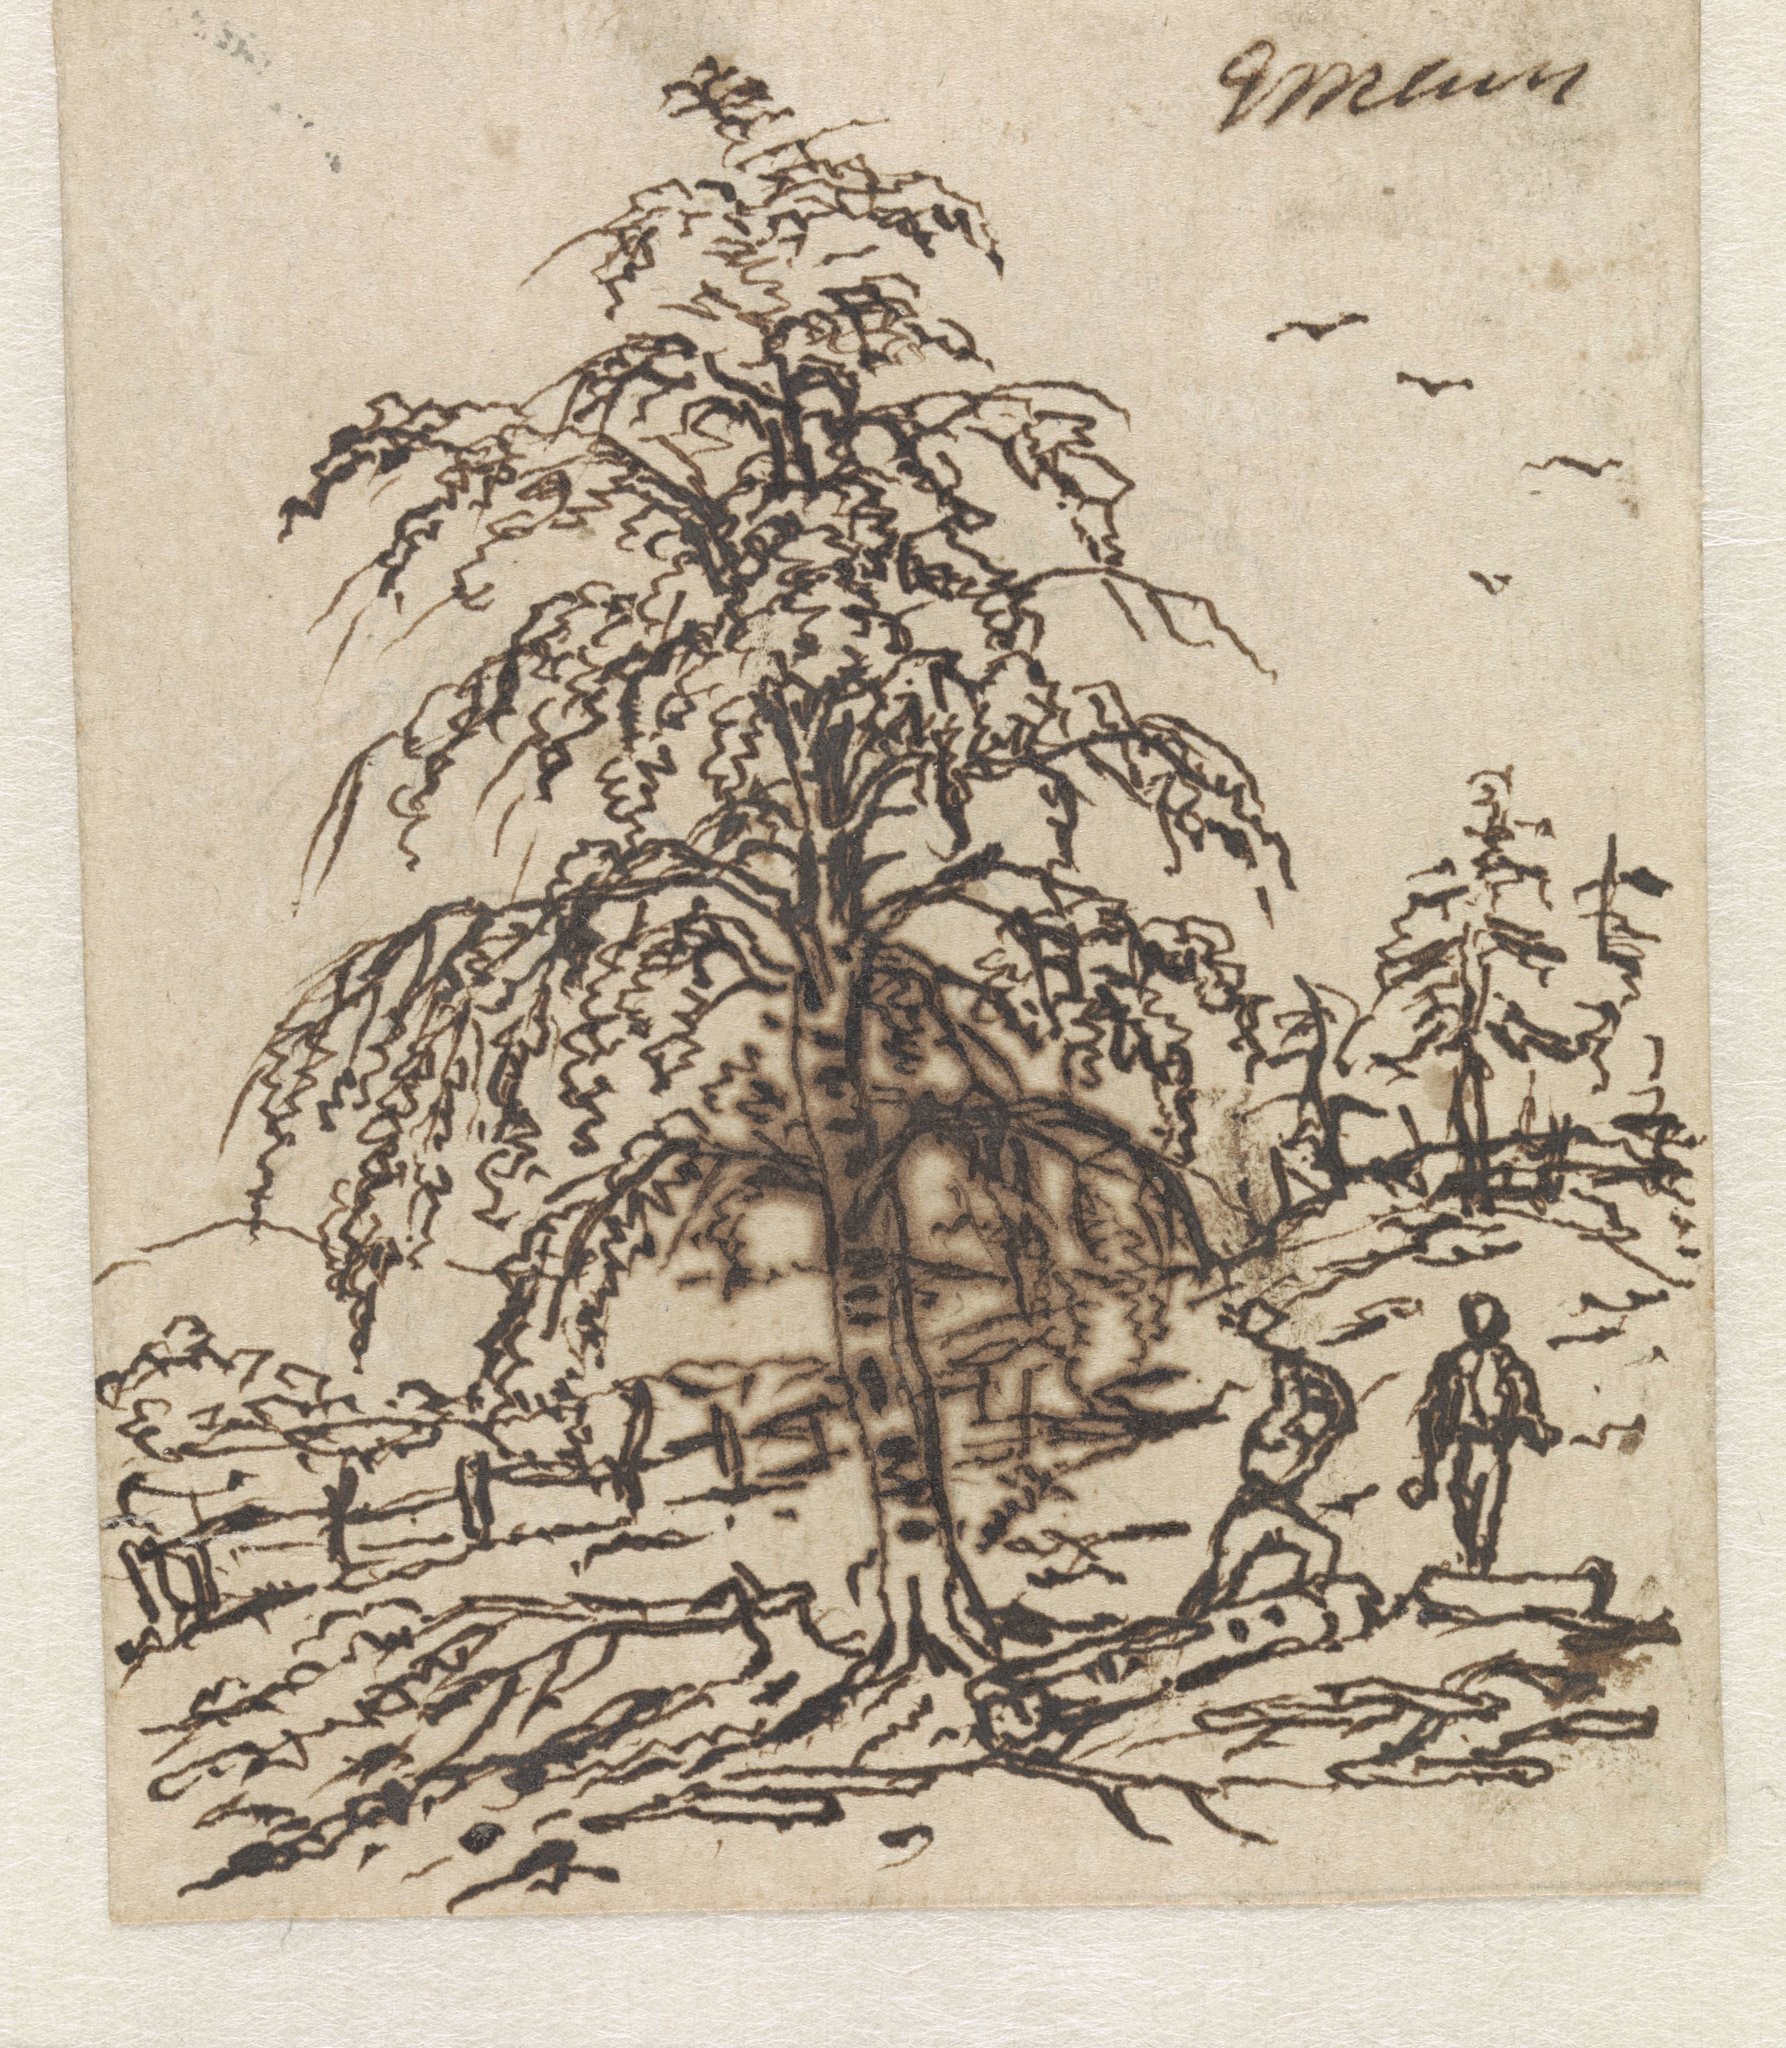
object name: drawing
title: Landschap met houthakker onder boom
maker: gerardus emaus de micault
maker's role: draughtsman, print maker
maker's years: 1798-1863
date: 1799-1863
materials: ink, paper, pencil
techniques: brush, pen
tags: woodcutting, woodcutter ~ forestry